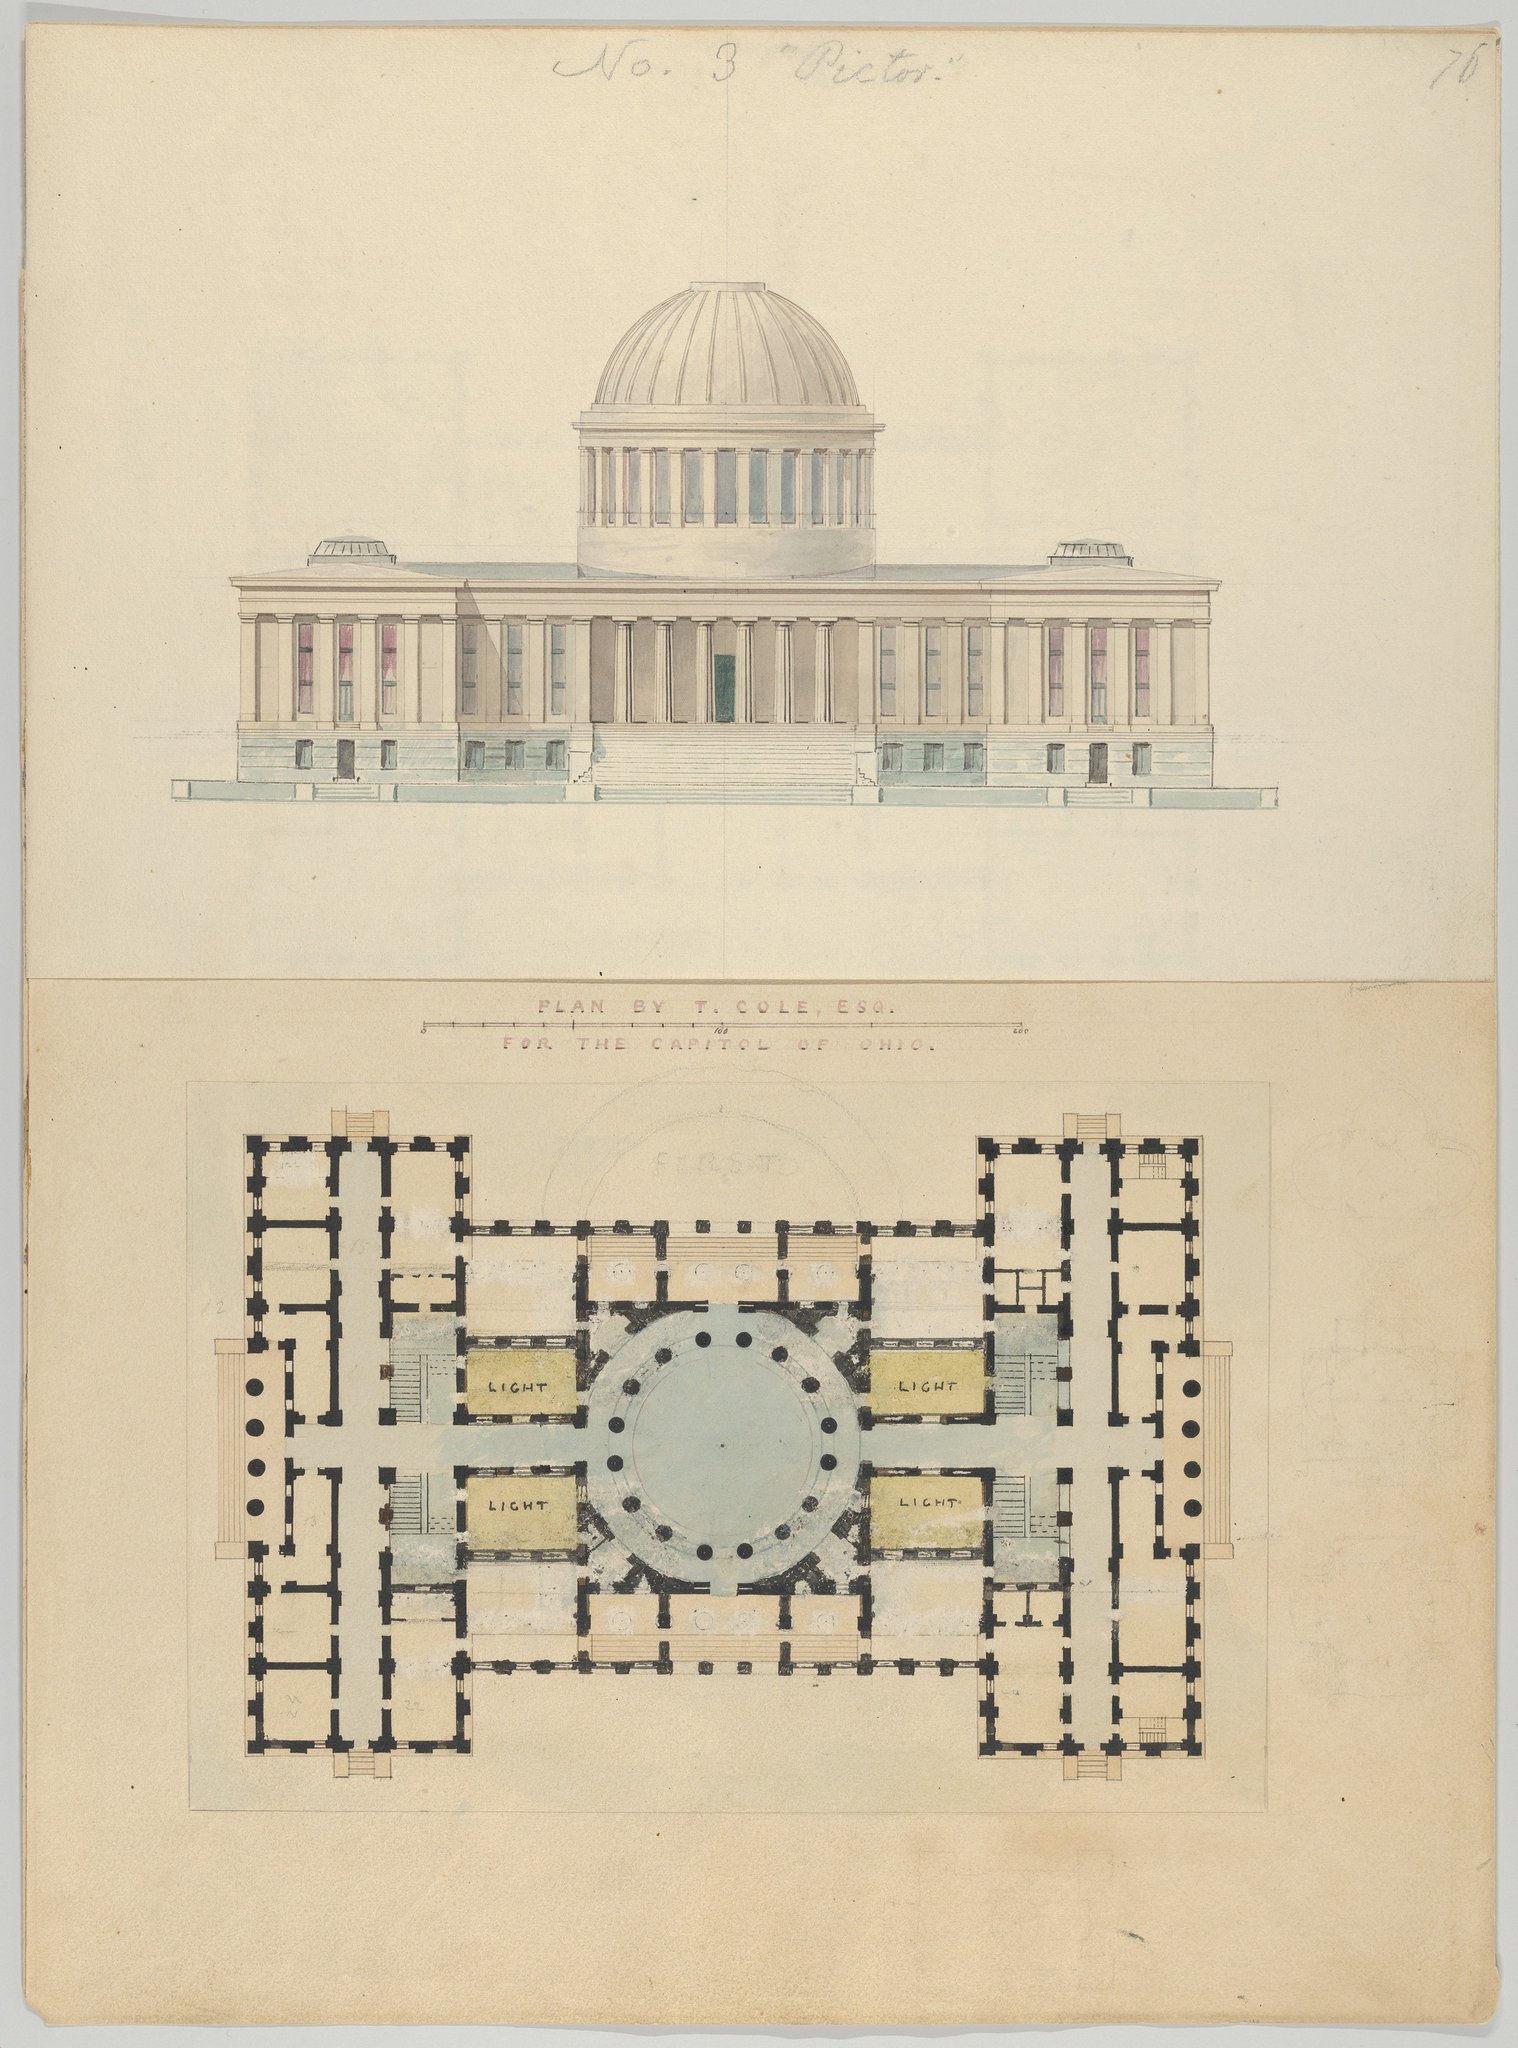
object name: drawing ornament architecture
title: Plan by T. Cole, Esq. for the Capitol of Ohio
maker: alexander jackson davis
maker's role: artist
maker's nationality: american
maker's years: 1803-1892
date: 1839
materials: graphite, ink, watercolor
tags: architecture,buildings